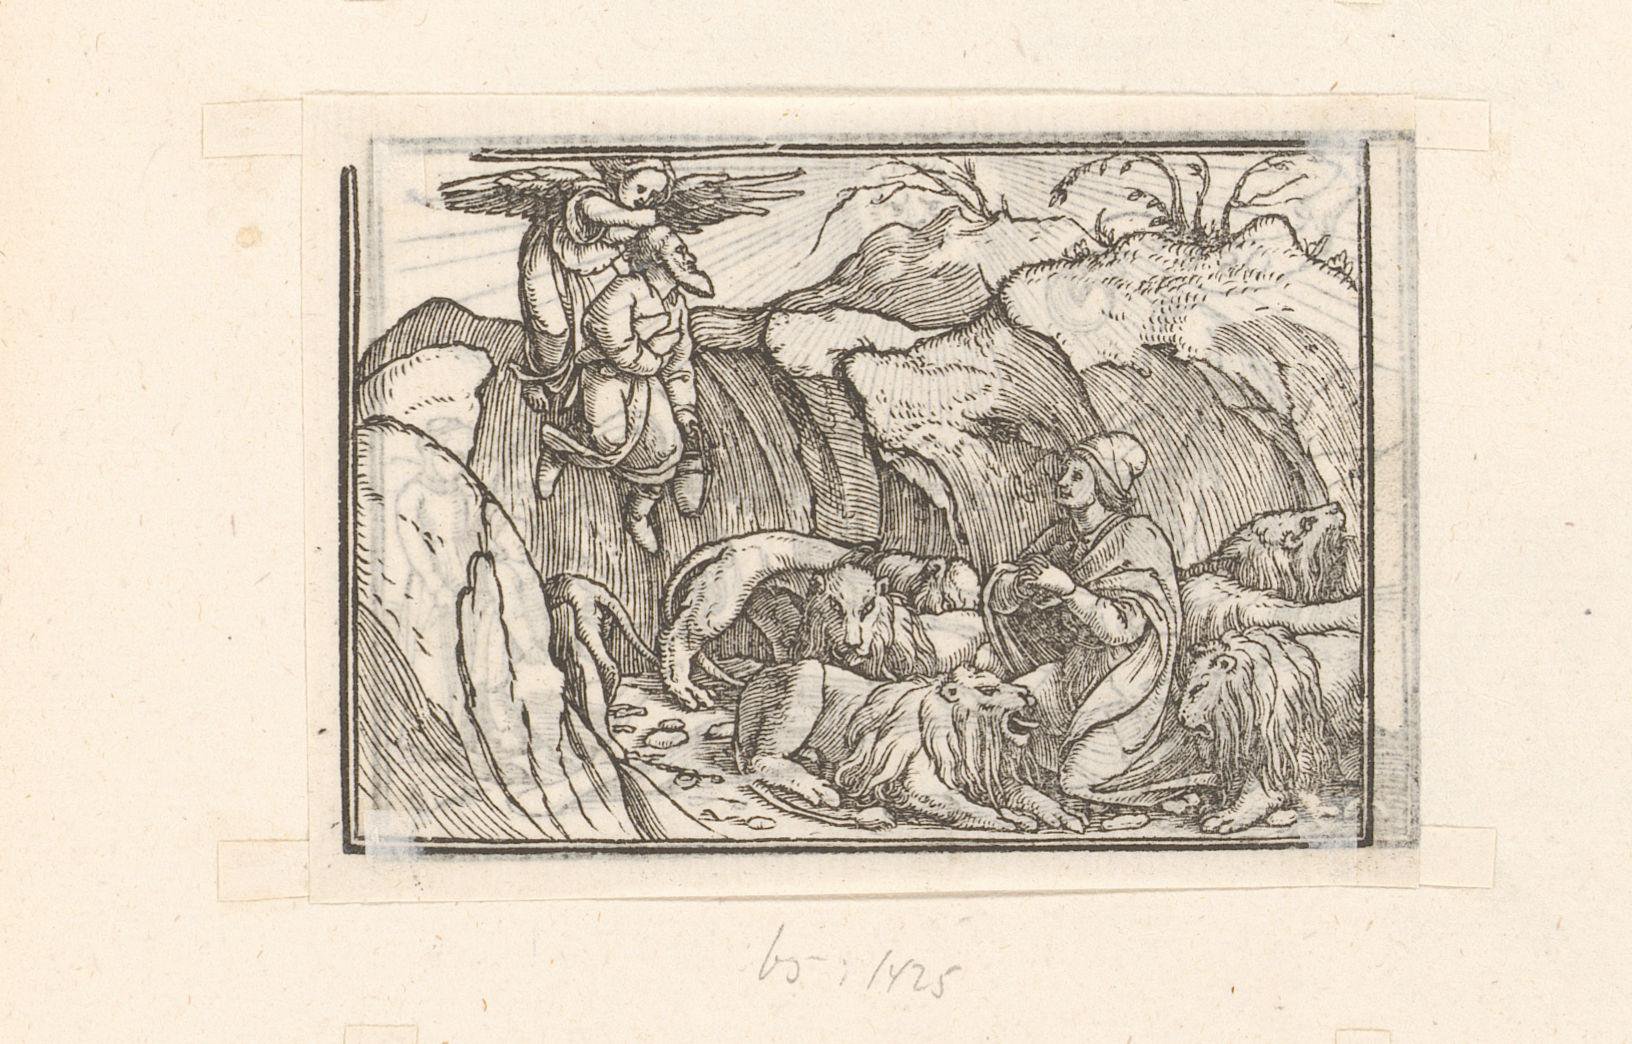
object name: print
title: Geschiedenis van het Oude Testament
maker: veit rudolf specklin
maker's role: print maker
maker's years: -1550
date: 1538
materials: paper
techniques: woodcut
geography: switzerland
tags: the prophet habakkuk, carried by his hair by an angel, brings food to daniel who sits unharmed between the lions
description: Boekillustratie voor het eerst gebruikt in: Biblia Utriusque Testamenti iuxta Vulgatam Translationem, Lyon, M. en G. Trechsel (voor Hugo à Porta) 1538. Later in verschillende uitgaven opnieuw gebruikt. Deze prent vermoedelijk gebruikt in één van de uitgaven uitgegeven en/of gedrukt door Jean Frellon, Lyon.